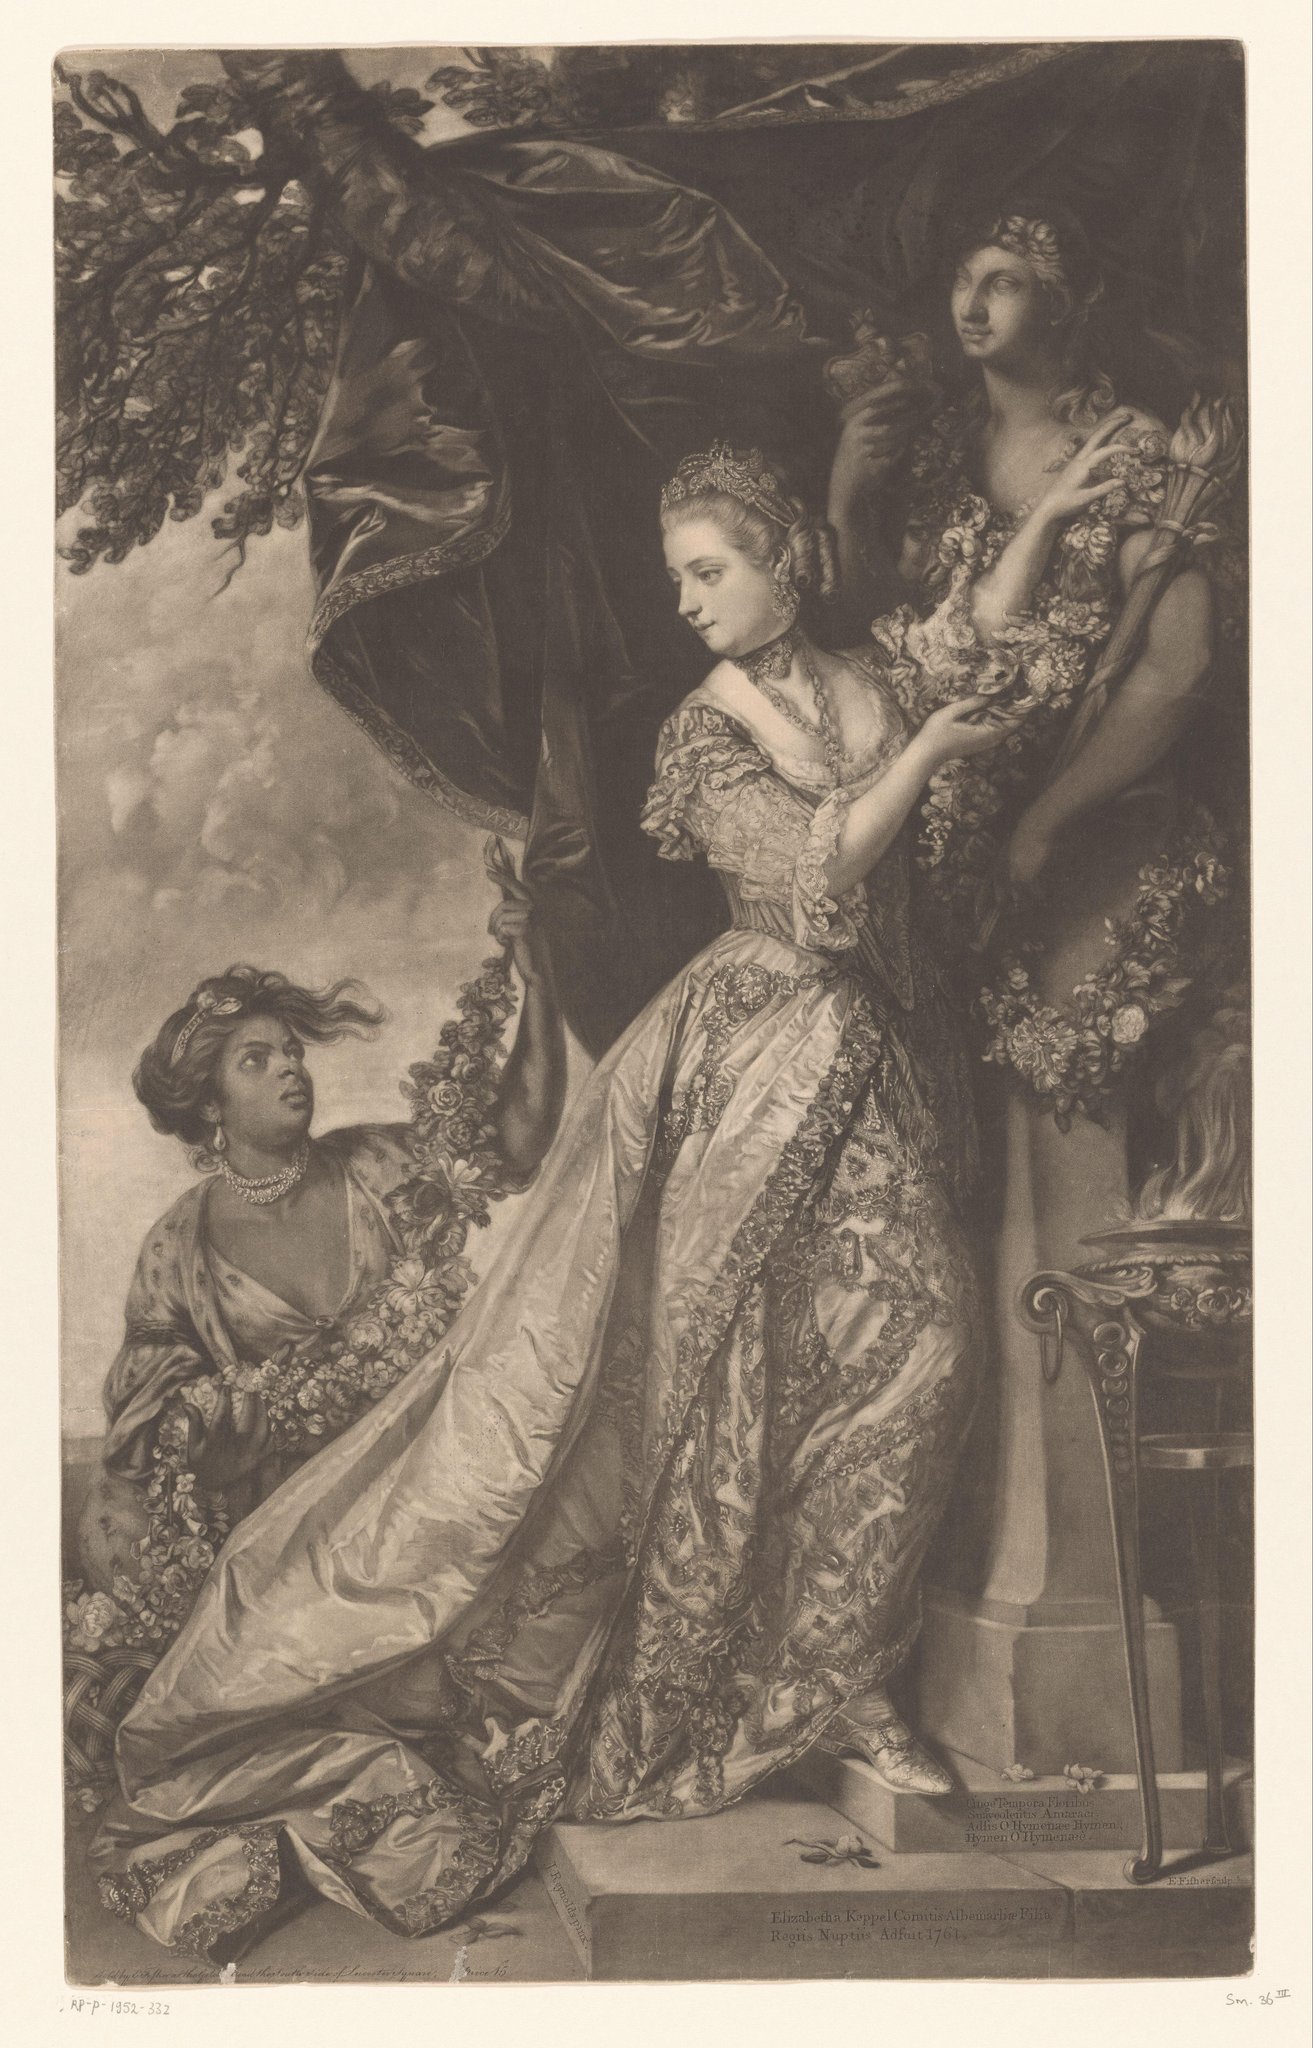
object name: print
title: Portret van Elisabeth Keppel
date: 1761-1785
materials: paper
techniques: mezzotint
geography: london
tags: historical persons, page ~ court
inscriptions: collector's mark: Lugt 2228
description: Tekst in het Engels in de prent. Guirlandes vastgehouden door de zwarte page, terwijl de witte vrouw bloemenkransen om een beeld op een altaar hangt.